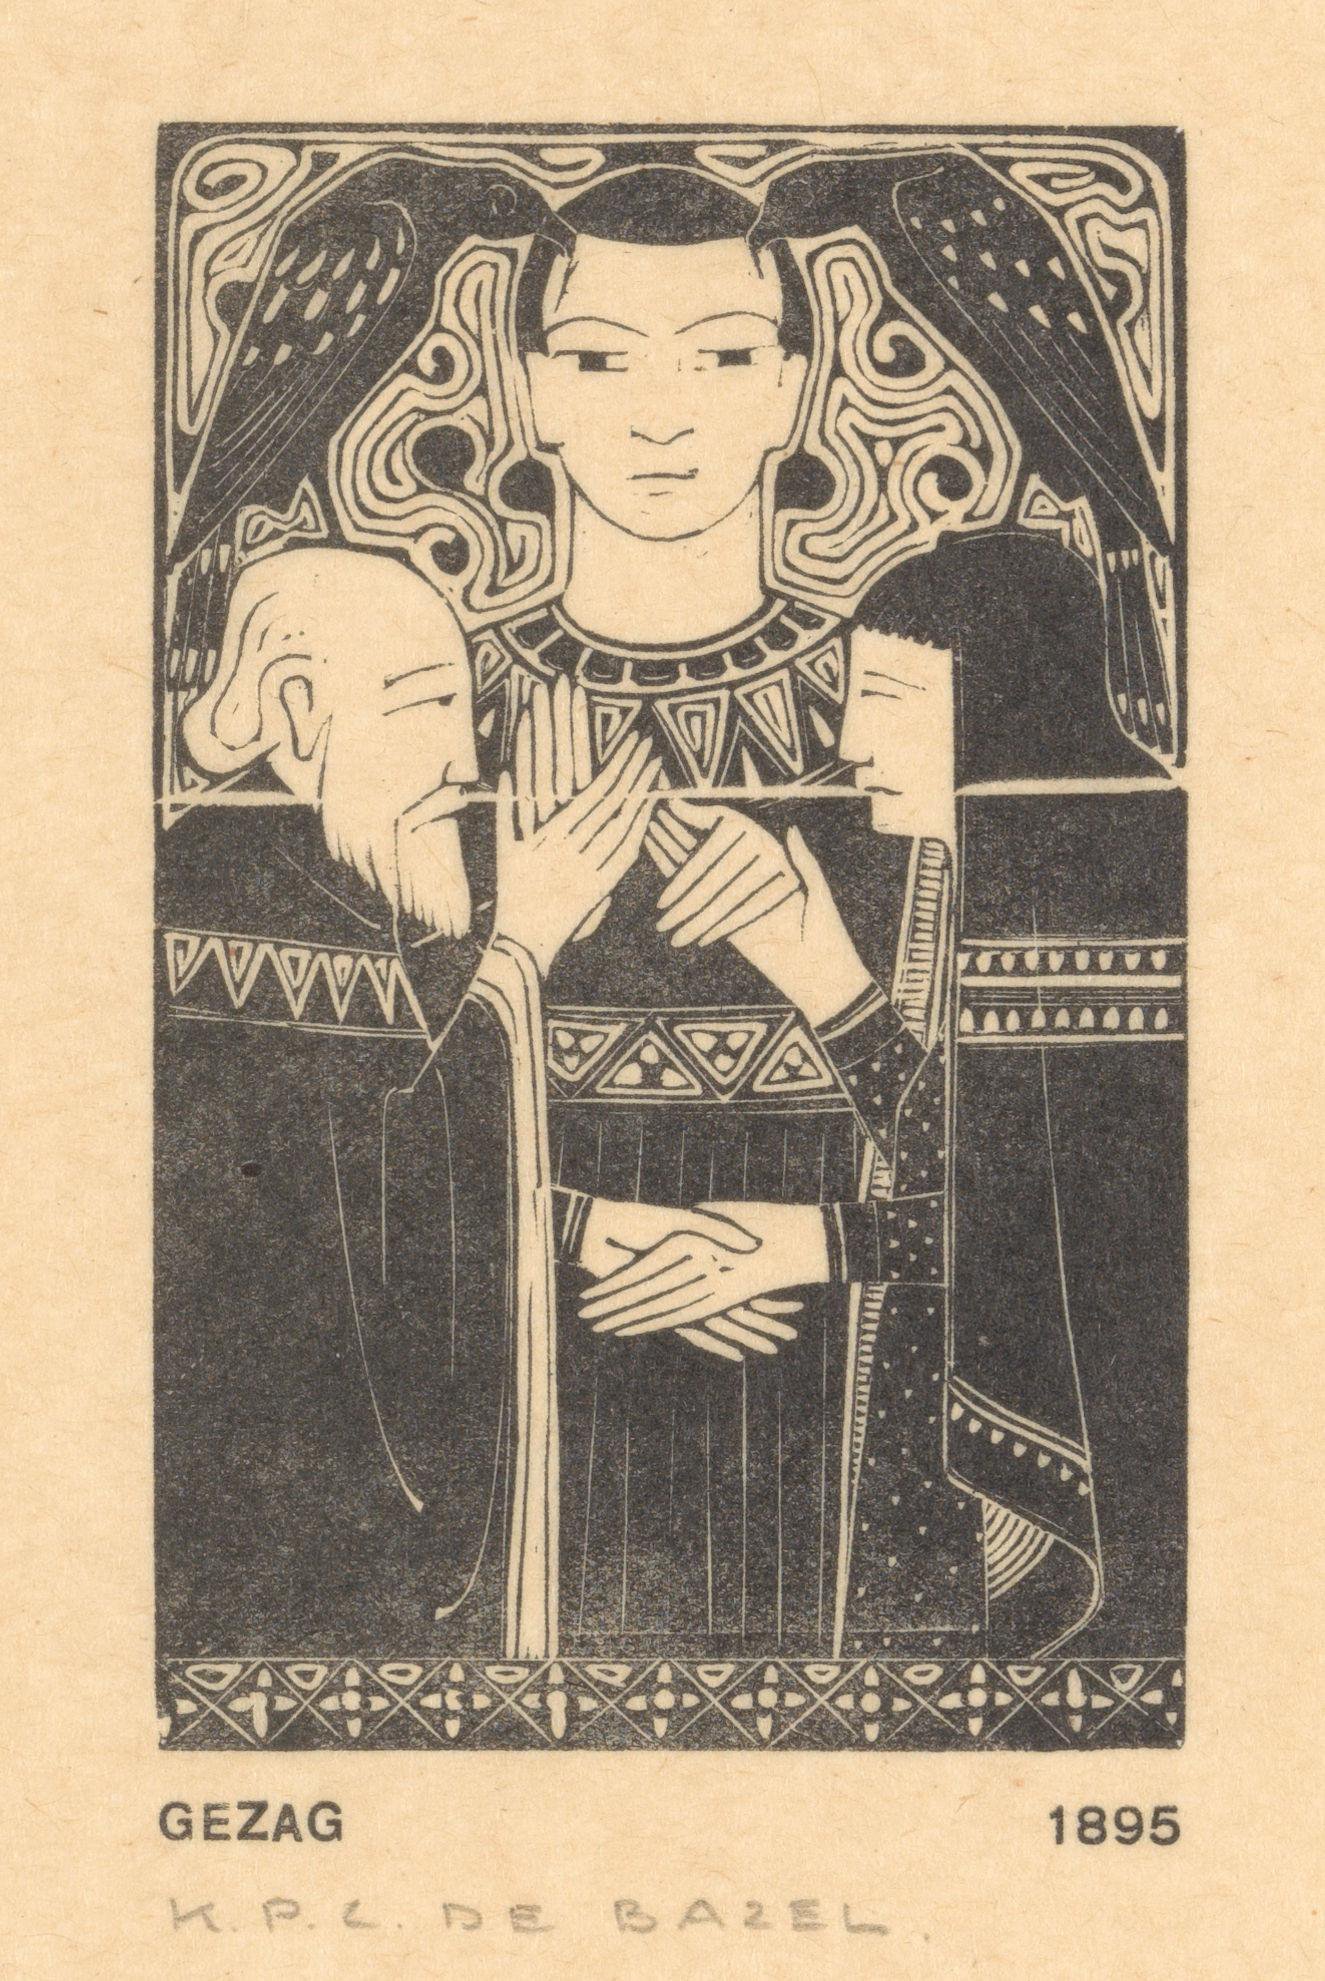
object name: illustration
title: Engel bij een man en vrouw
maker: karel petrus cornelis de bazel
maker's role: draughtsman, print maker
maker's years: 1869-1923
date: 1895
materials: paper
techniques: woodcut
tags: angels, gripping someone by the hand or the wrist; clasped hands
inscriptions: annotation: ‘gezag’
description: Prent afkomstig uit: Wendingen. Amsterdam: De Hooge Brug, 1919. Jaargang 2, nummer 7-8. De prent is oorspronkelijk als illustratie verschenen in het tijdschrift 'Licht en Waarheid' V, nr. 136 (1 juni 1895). De huidige titel is door het museum toegekend bij gebrek aan informatie over een originele titel.